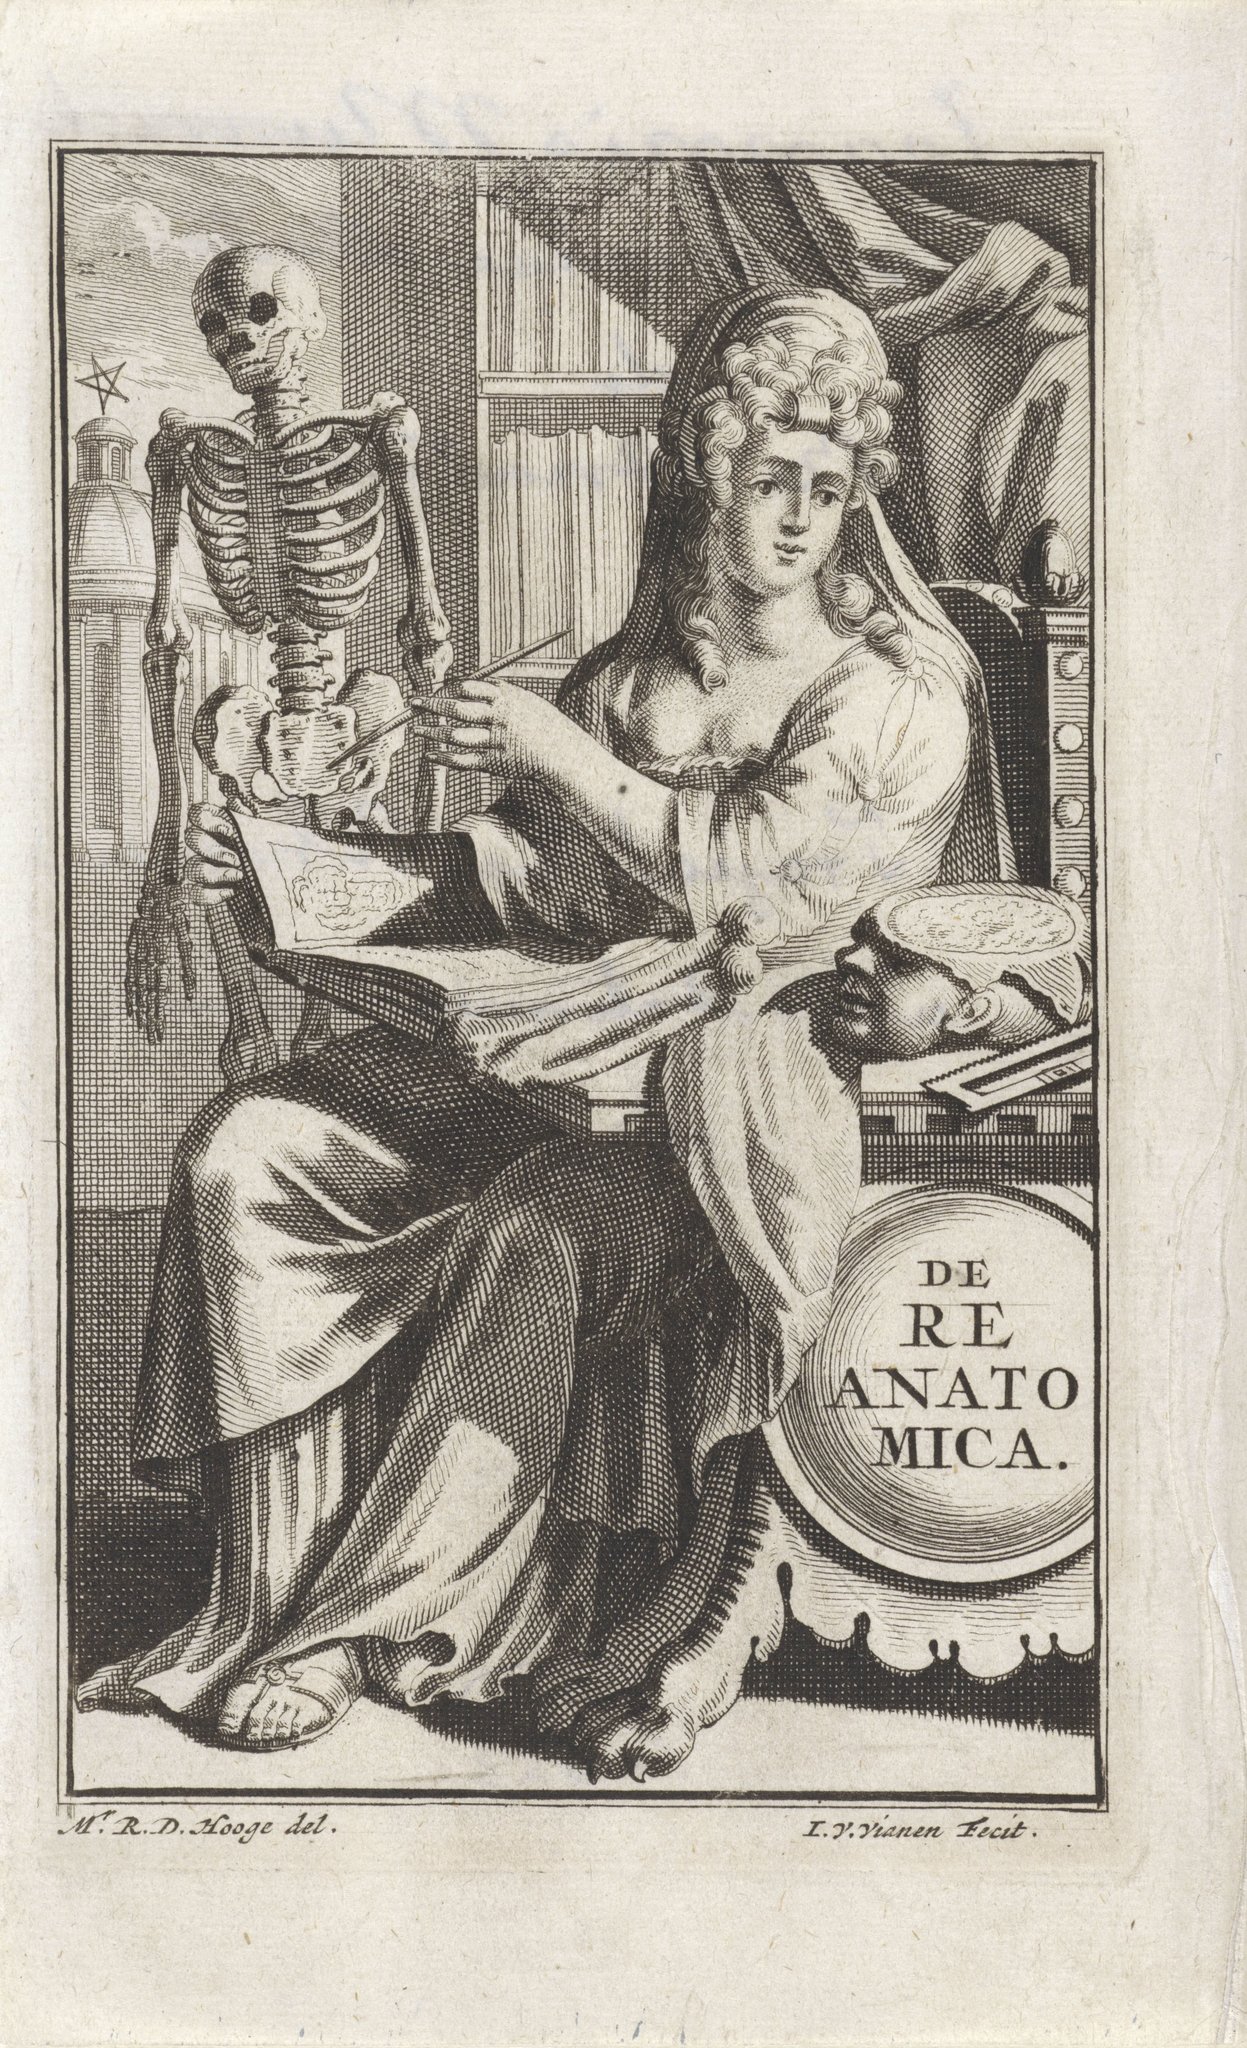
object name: titelblad, titelpagina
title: Titelpagina voor: J. Munnicks, De re anatomica liber, 1697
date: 1697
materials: paper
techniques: engraving, etching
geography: utrecht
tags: physiology and anatomy, (human) skeleton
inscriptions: collector's mark: Lugt 2228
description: Een vrouw heeft een boek op schoot met anatomische afbeeldingen. Naast haar op tafel ligt een opengelegd menselijk hoofd en een bot. Achter haar een boekenkast en een menselijk geraamte.